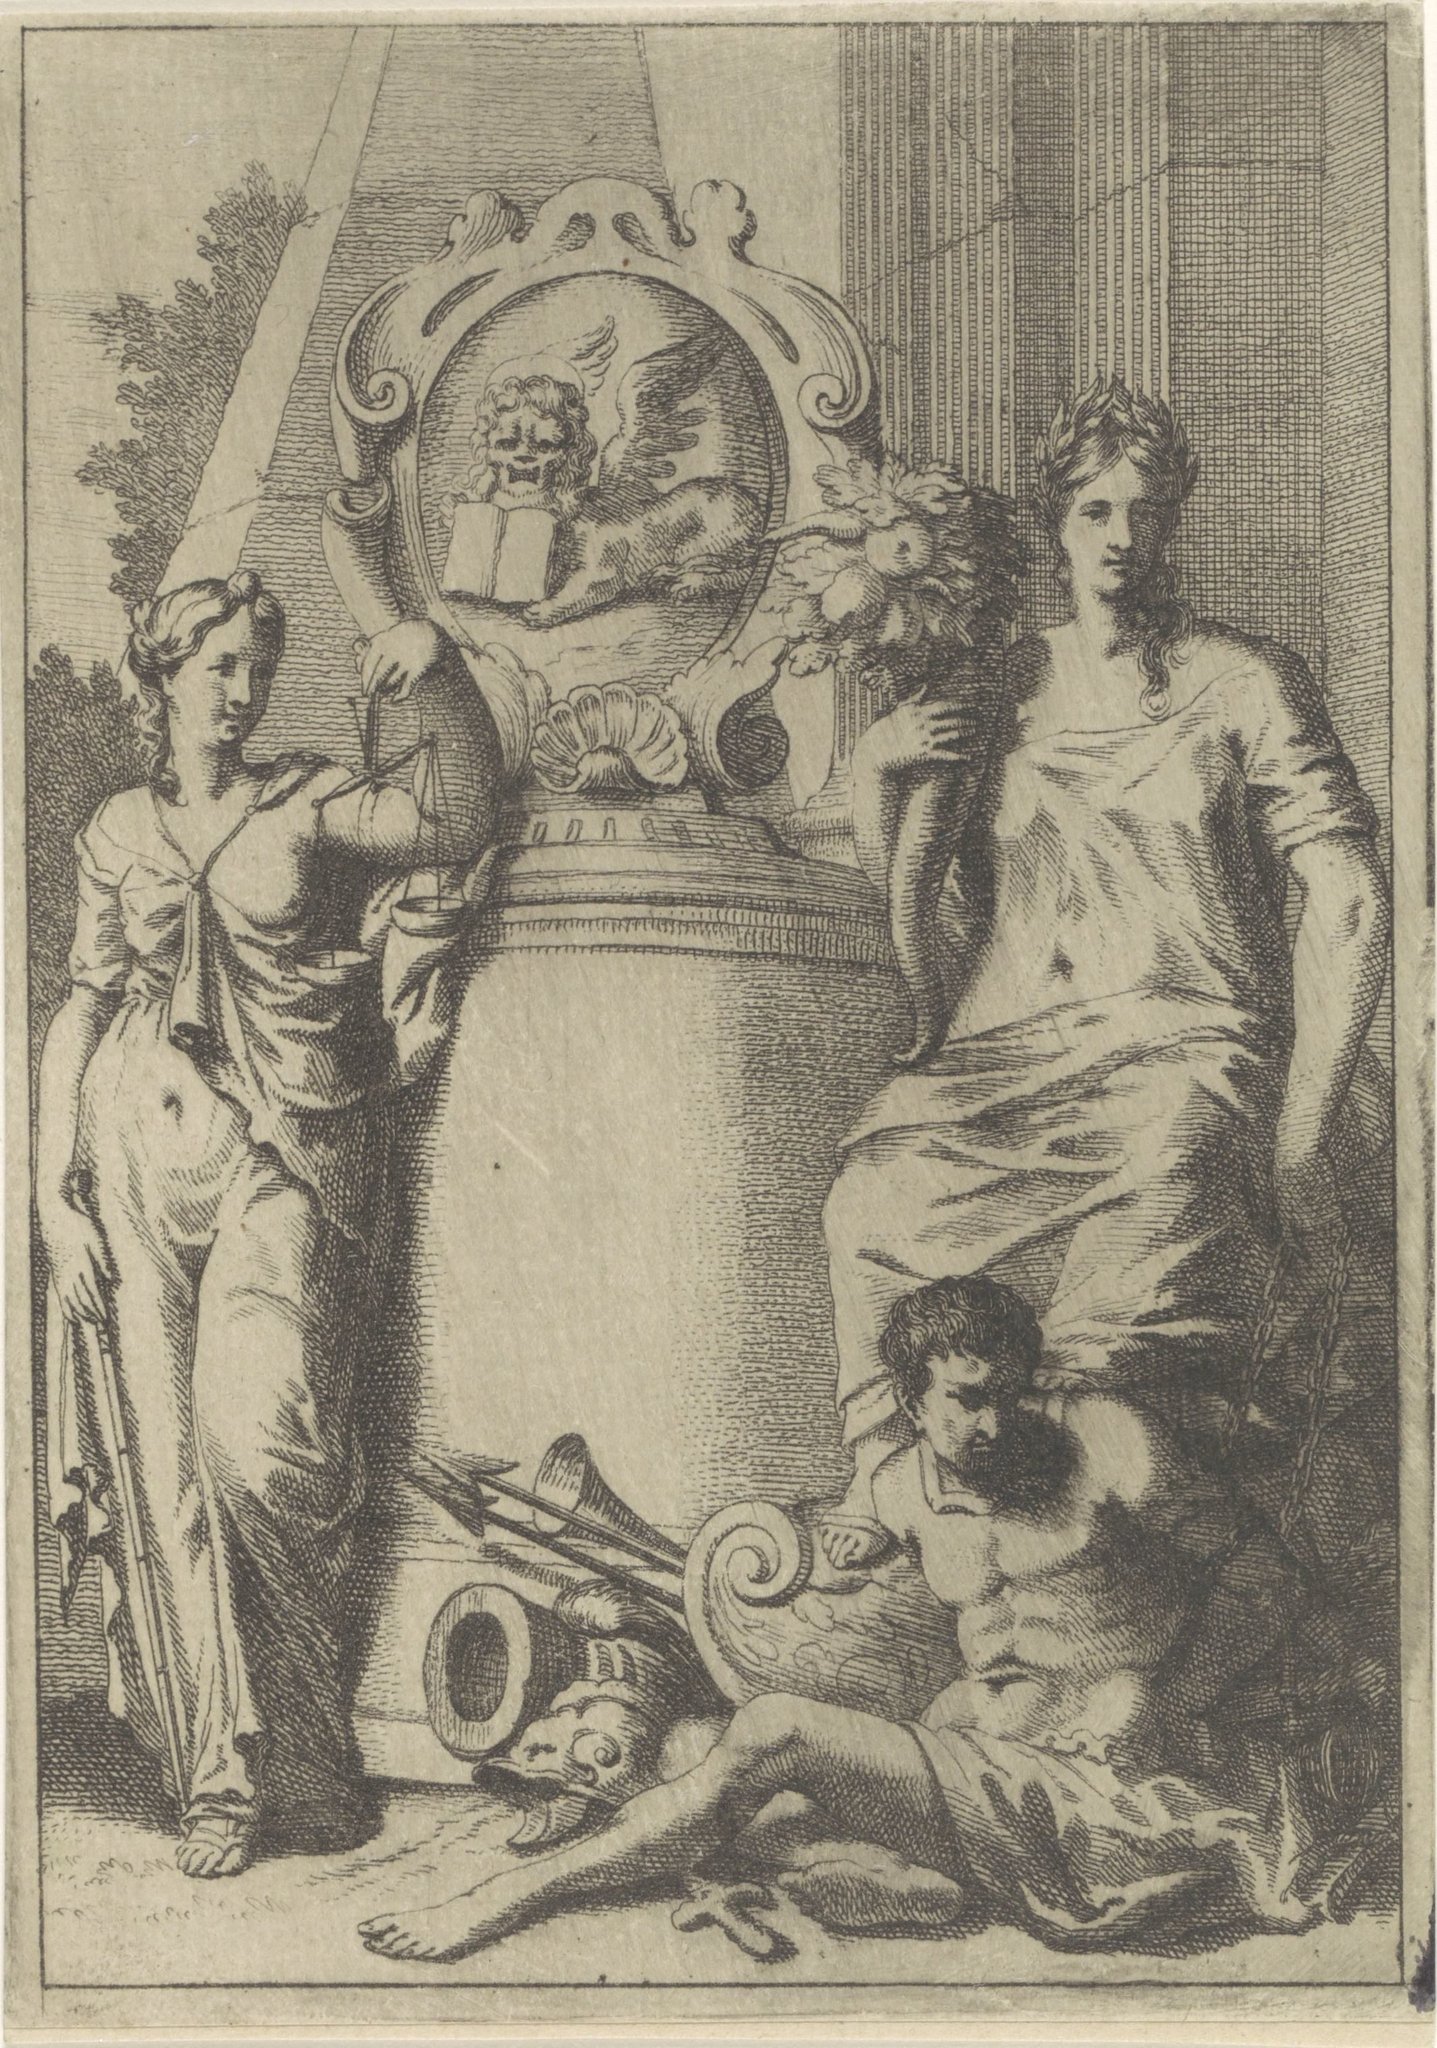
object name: print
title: Rechtvaardigheid en Overvloed naast een wapen met de leeuw van de evangelist Marcus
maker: Anonymous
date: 1700-1800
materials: paper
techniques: etching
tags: 'cornucopia', horn of plenty, justice, 'justitia'; 'giustitia divina' (ripa) ~ one of the four cardinal virtues, lion (possibly with book) ~ symbol of st. mark, abundance; 'abondanza', 'abondanza maritima' (ripa)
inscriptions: collector's mark: Lugt 2228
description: De personificatie van Rechtvaardigheid, met de weegschaal in de hand, en de personificatie van de Overvloed, met de hoorn des overvloeds, staan naast een zuil met bovenop het wapen met de leeuw van de evangelist Marcus. Mogelijk is dit het wapenschild van Venetië. De Overvloed houdt een ketting vast waaraan een overwonnen soldaat vastzit.